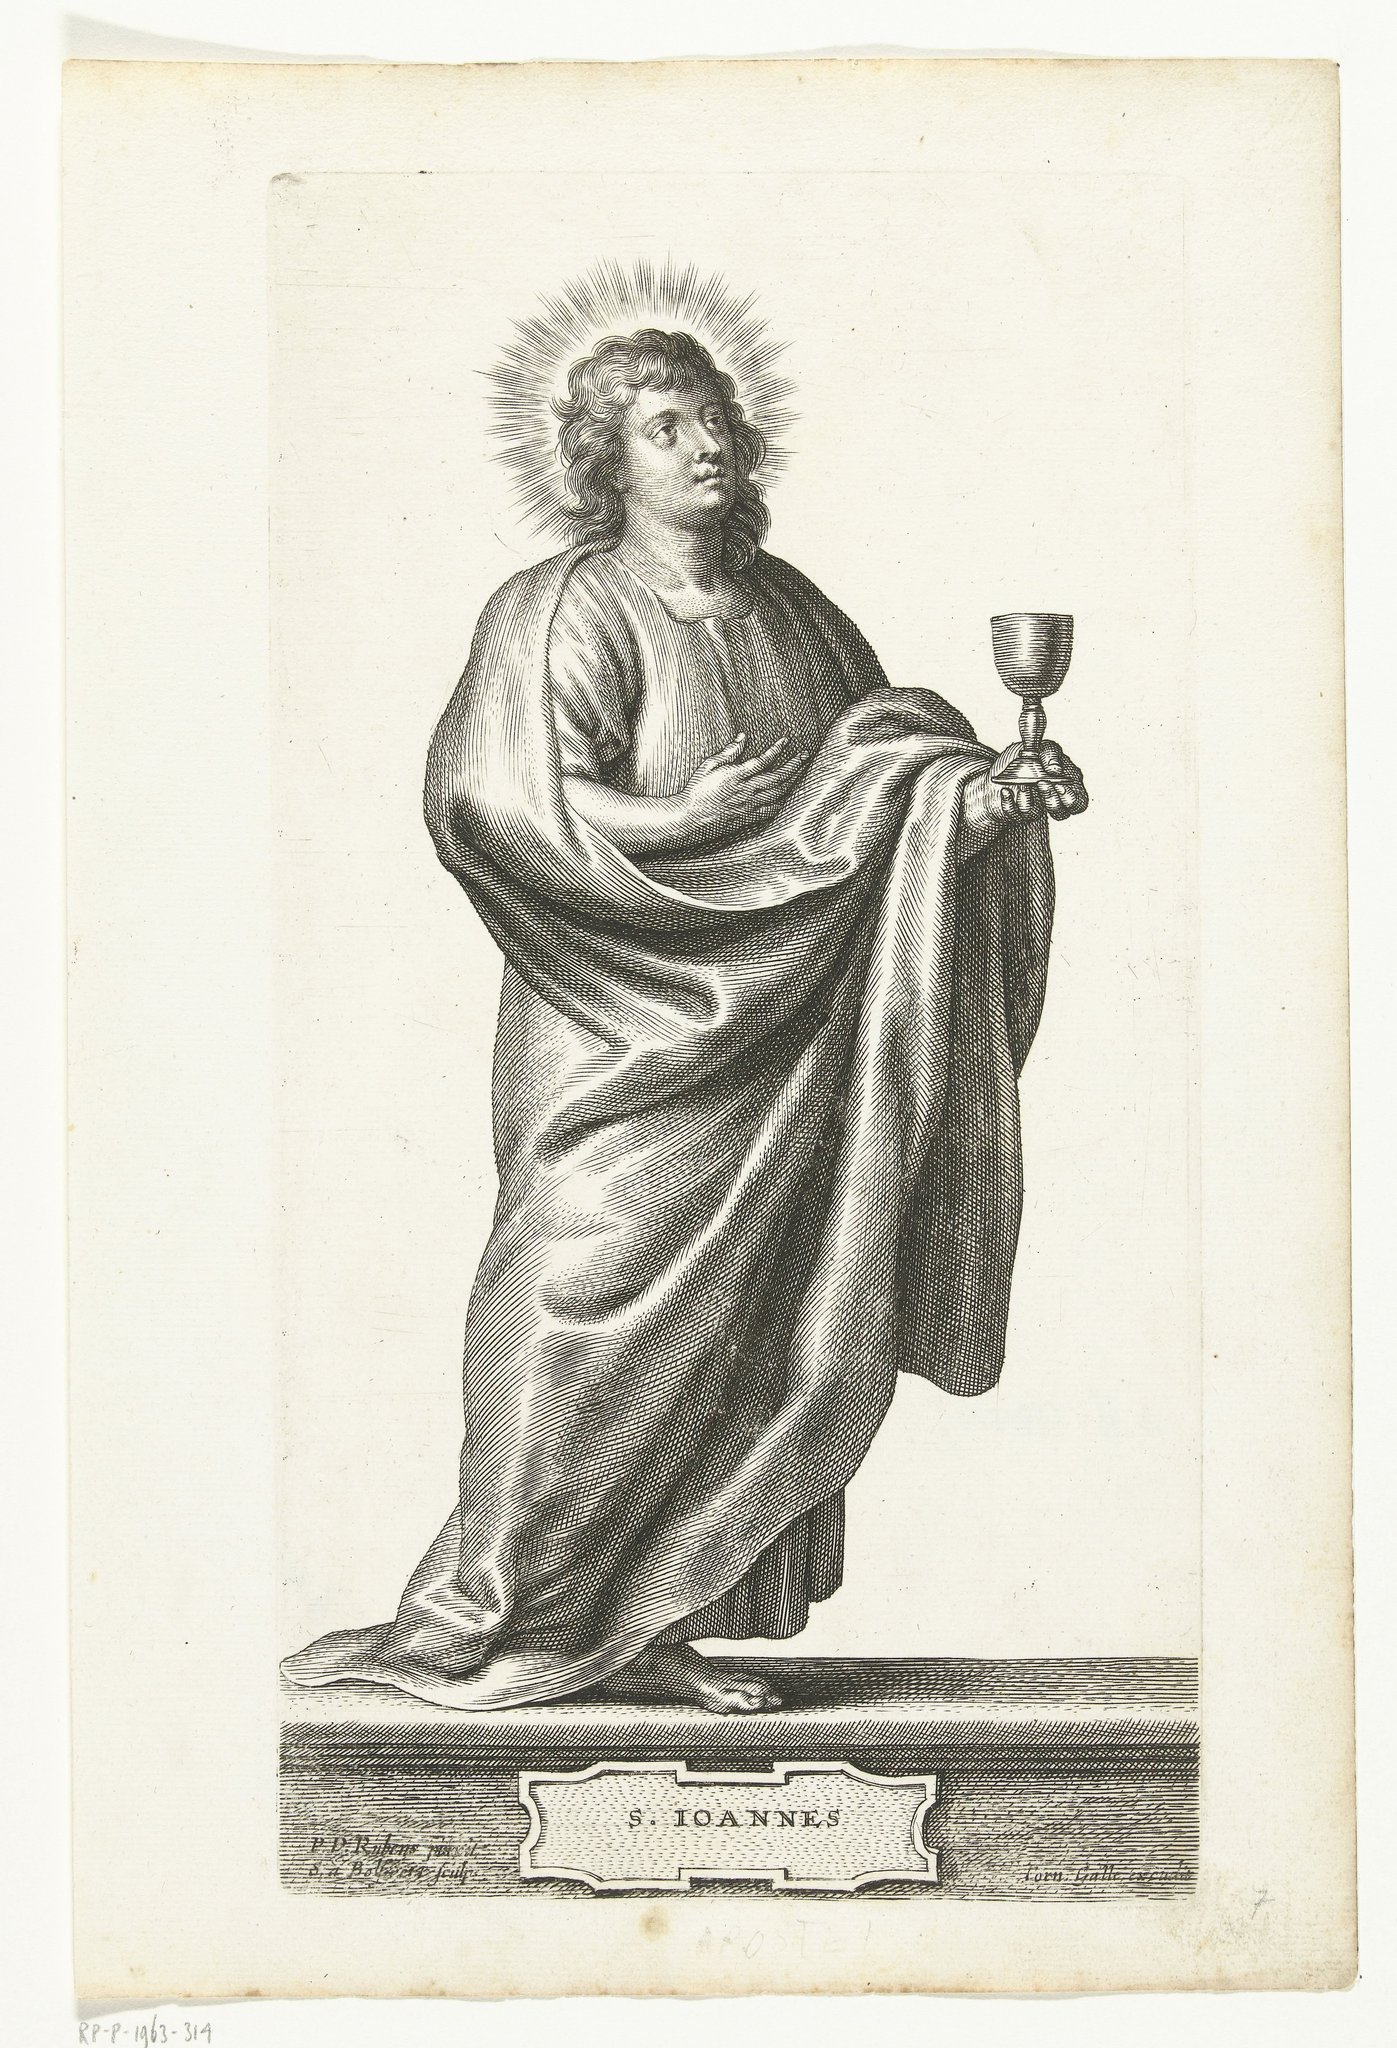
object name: print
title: S. Ioannes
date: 1596-1659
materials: paper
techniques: engraving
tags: the apostle john the evangelist; possible attributes: book, cauldron, chalice with snake, eagle, palm, scroll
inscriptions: collector's mark: Lugt 2228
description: Prent uit serie van vijftien prenten naar tekeningen van Peter Paul Rubens met de serietitel SS. Apostolorum Icones.